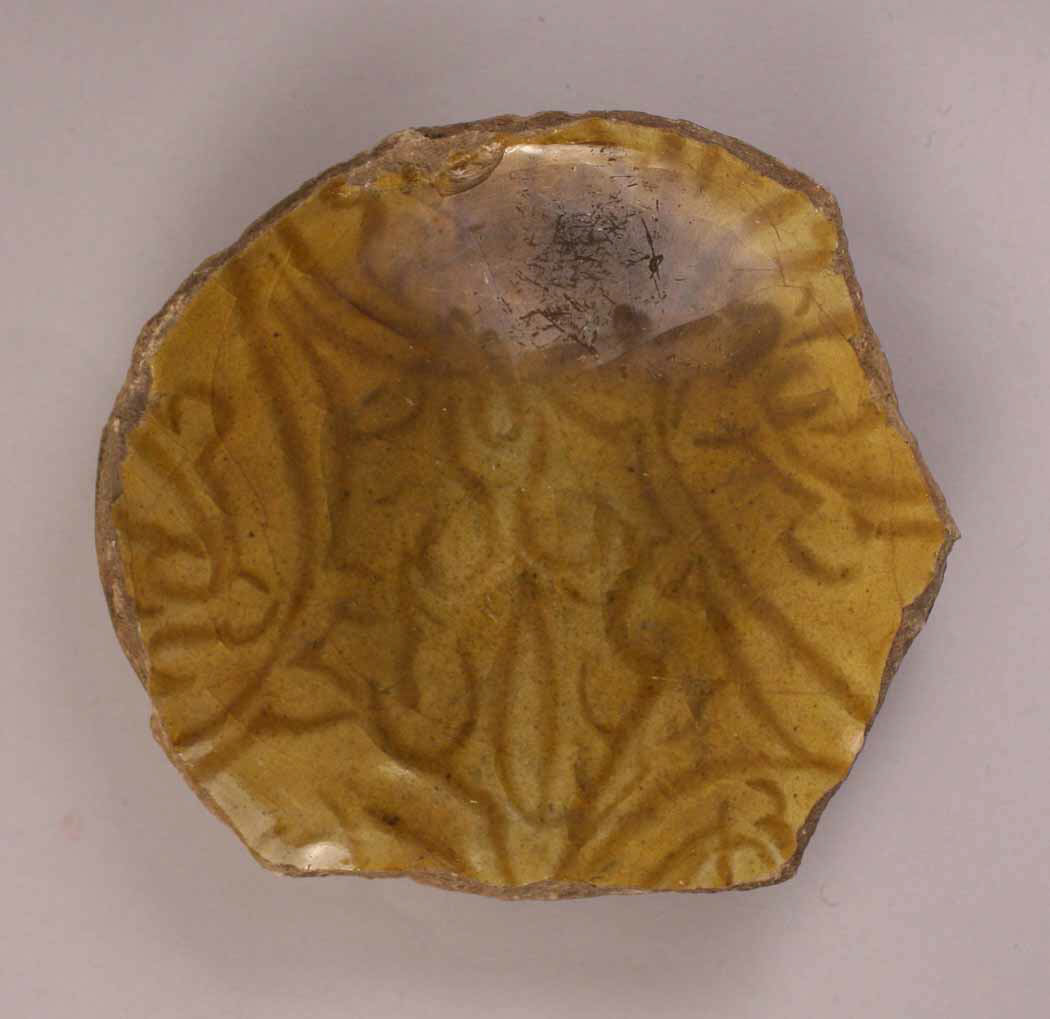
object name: ceramic fragment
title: Fragment of a Dish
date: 1201-1400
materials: earthenware, glaze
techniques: incising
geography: egypt